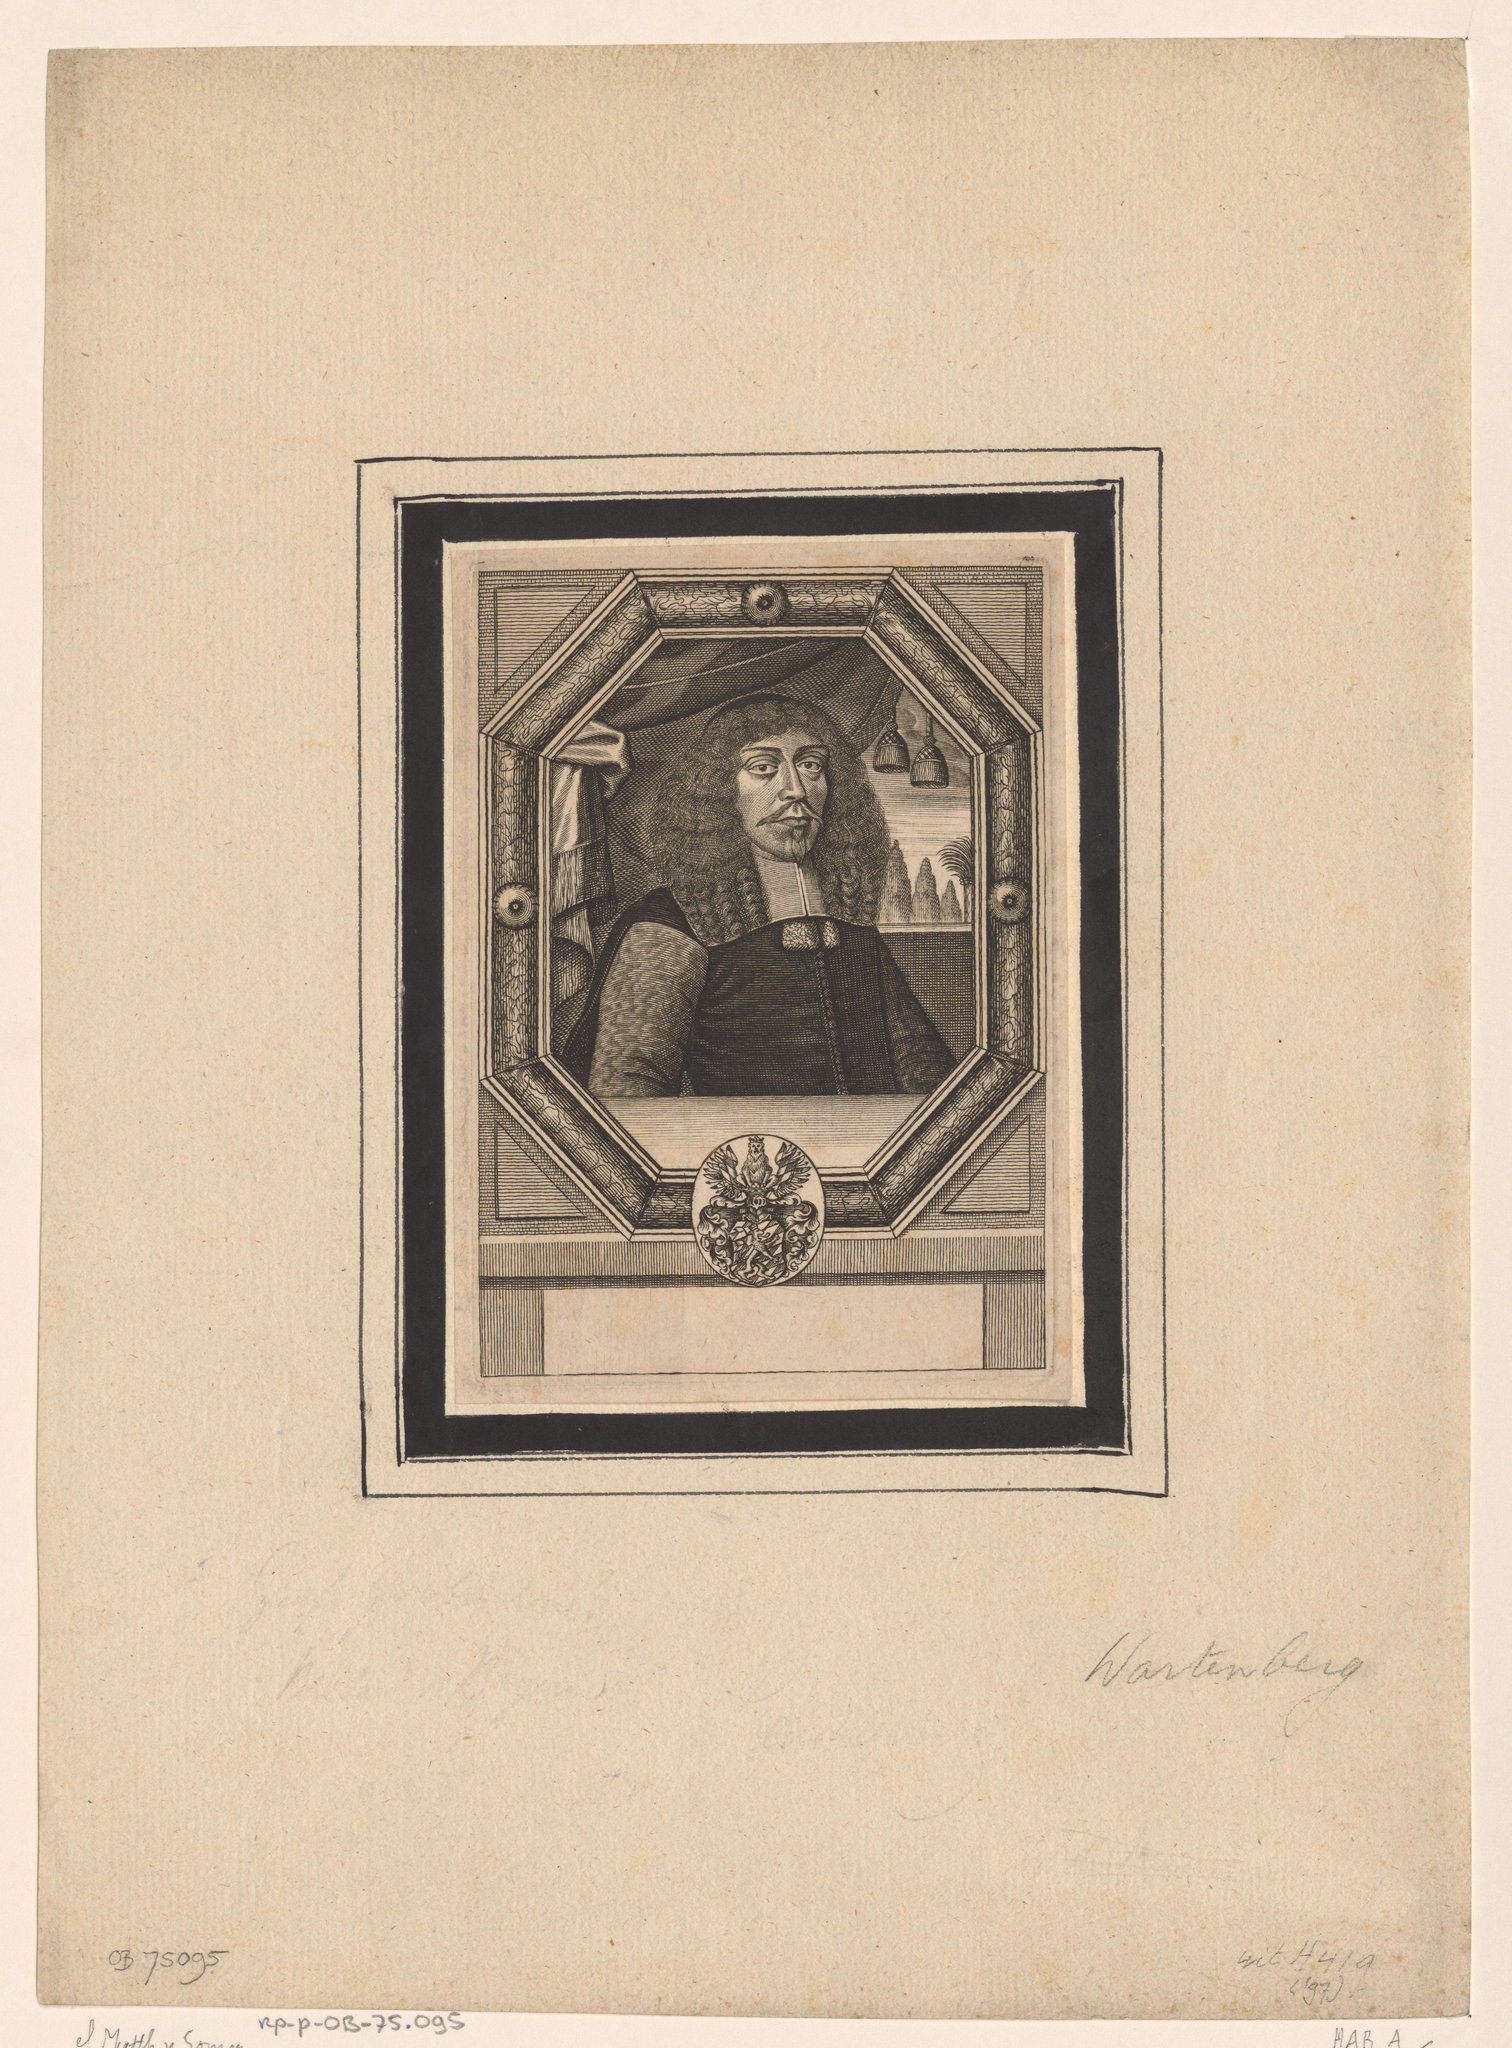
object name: print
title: Portret van een onbekende man, mogelijk een graaf van Wartenburg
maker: Anonymous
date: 1650-1750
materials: paper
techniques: engraving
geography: germany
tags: armorial bearing, heraldry, historical persons not known by name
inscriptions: collector's mark: Lugt 2228